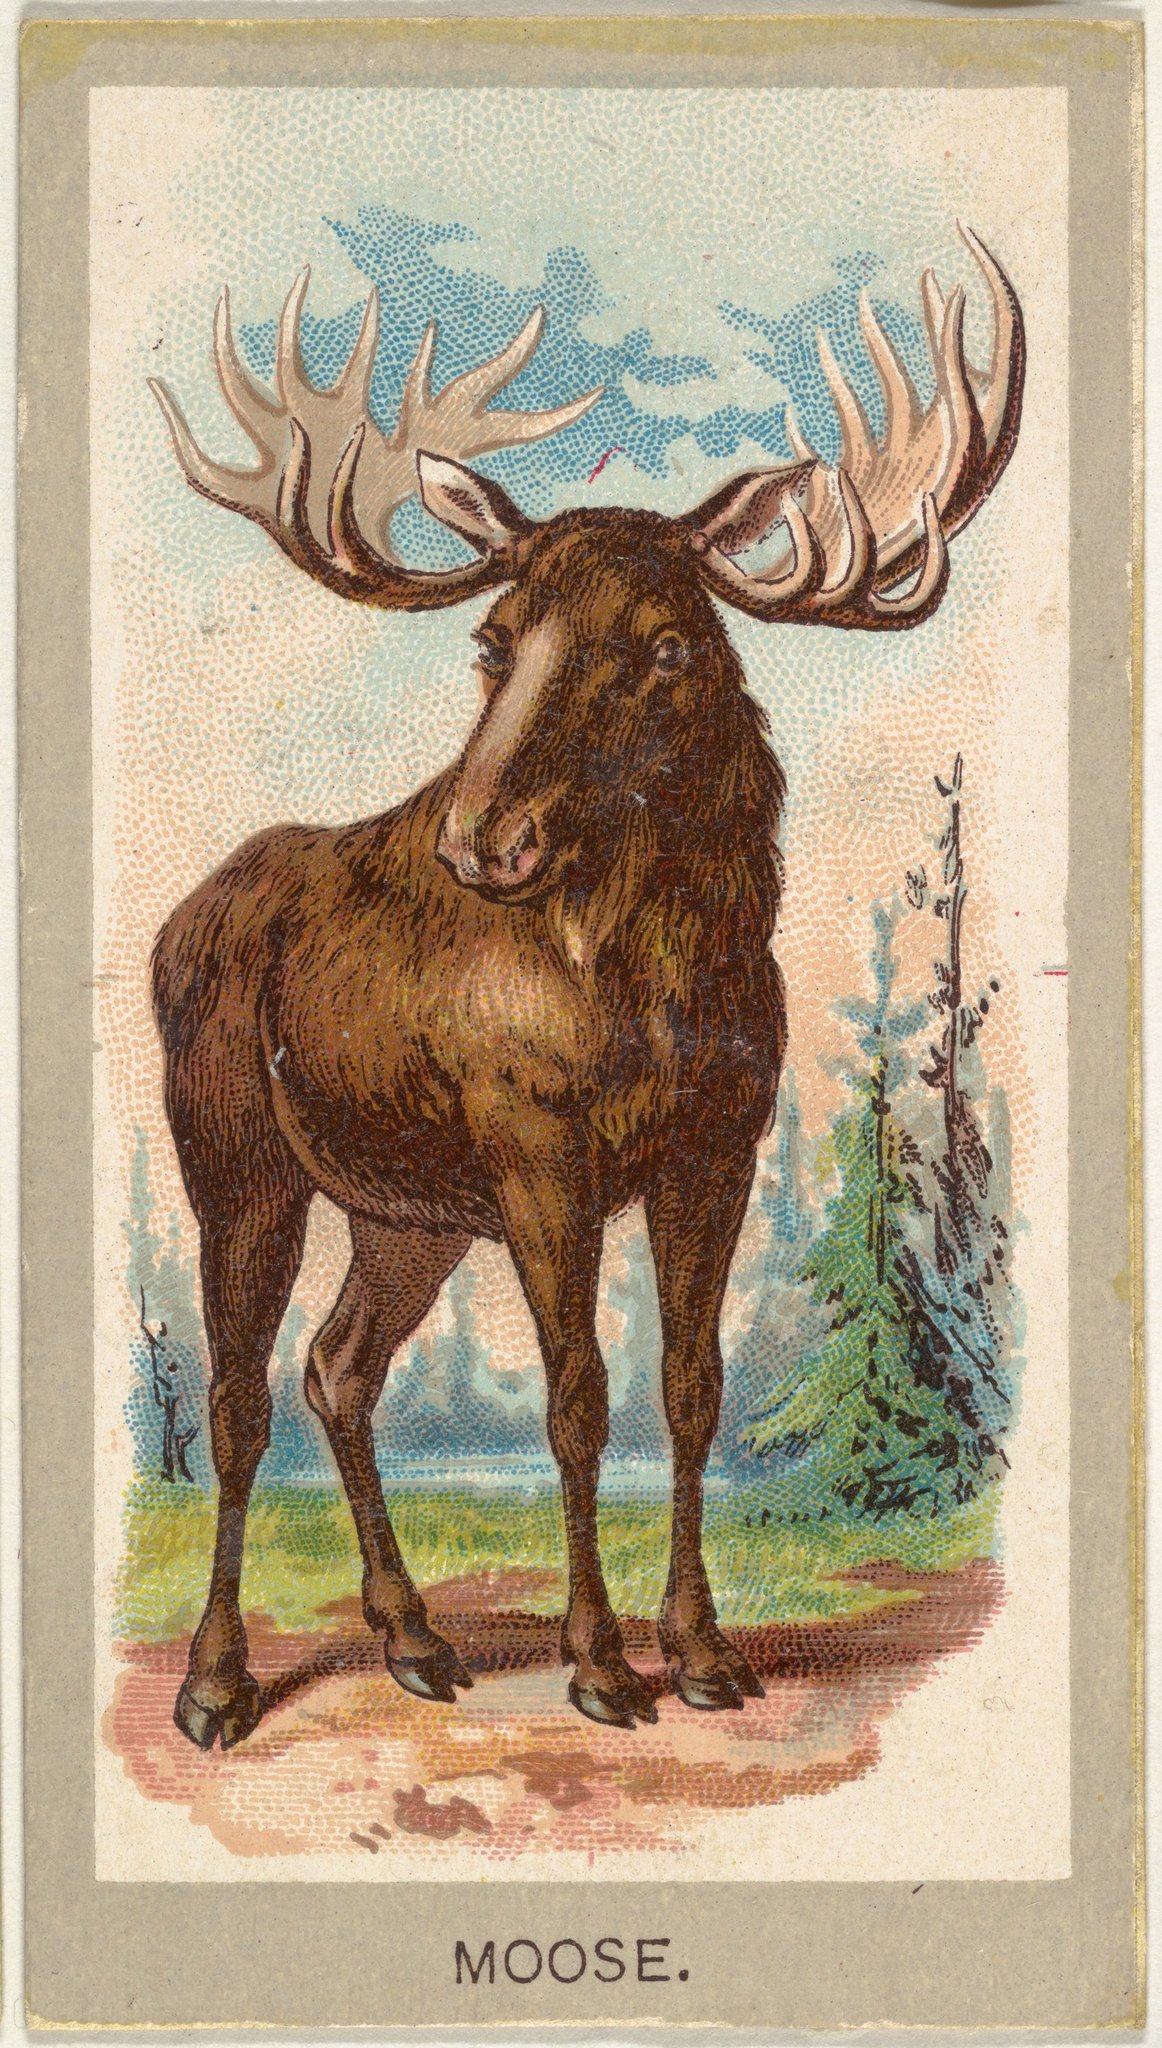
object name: print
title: Moose, from the Animals of the World series (T180), issued by Abdul Cigarettes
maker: abdul cigarettes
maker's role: publisher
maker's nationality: american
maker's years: 1881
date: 1881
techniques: color lithograph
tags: animals